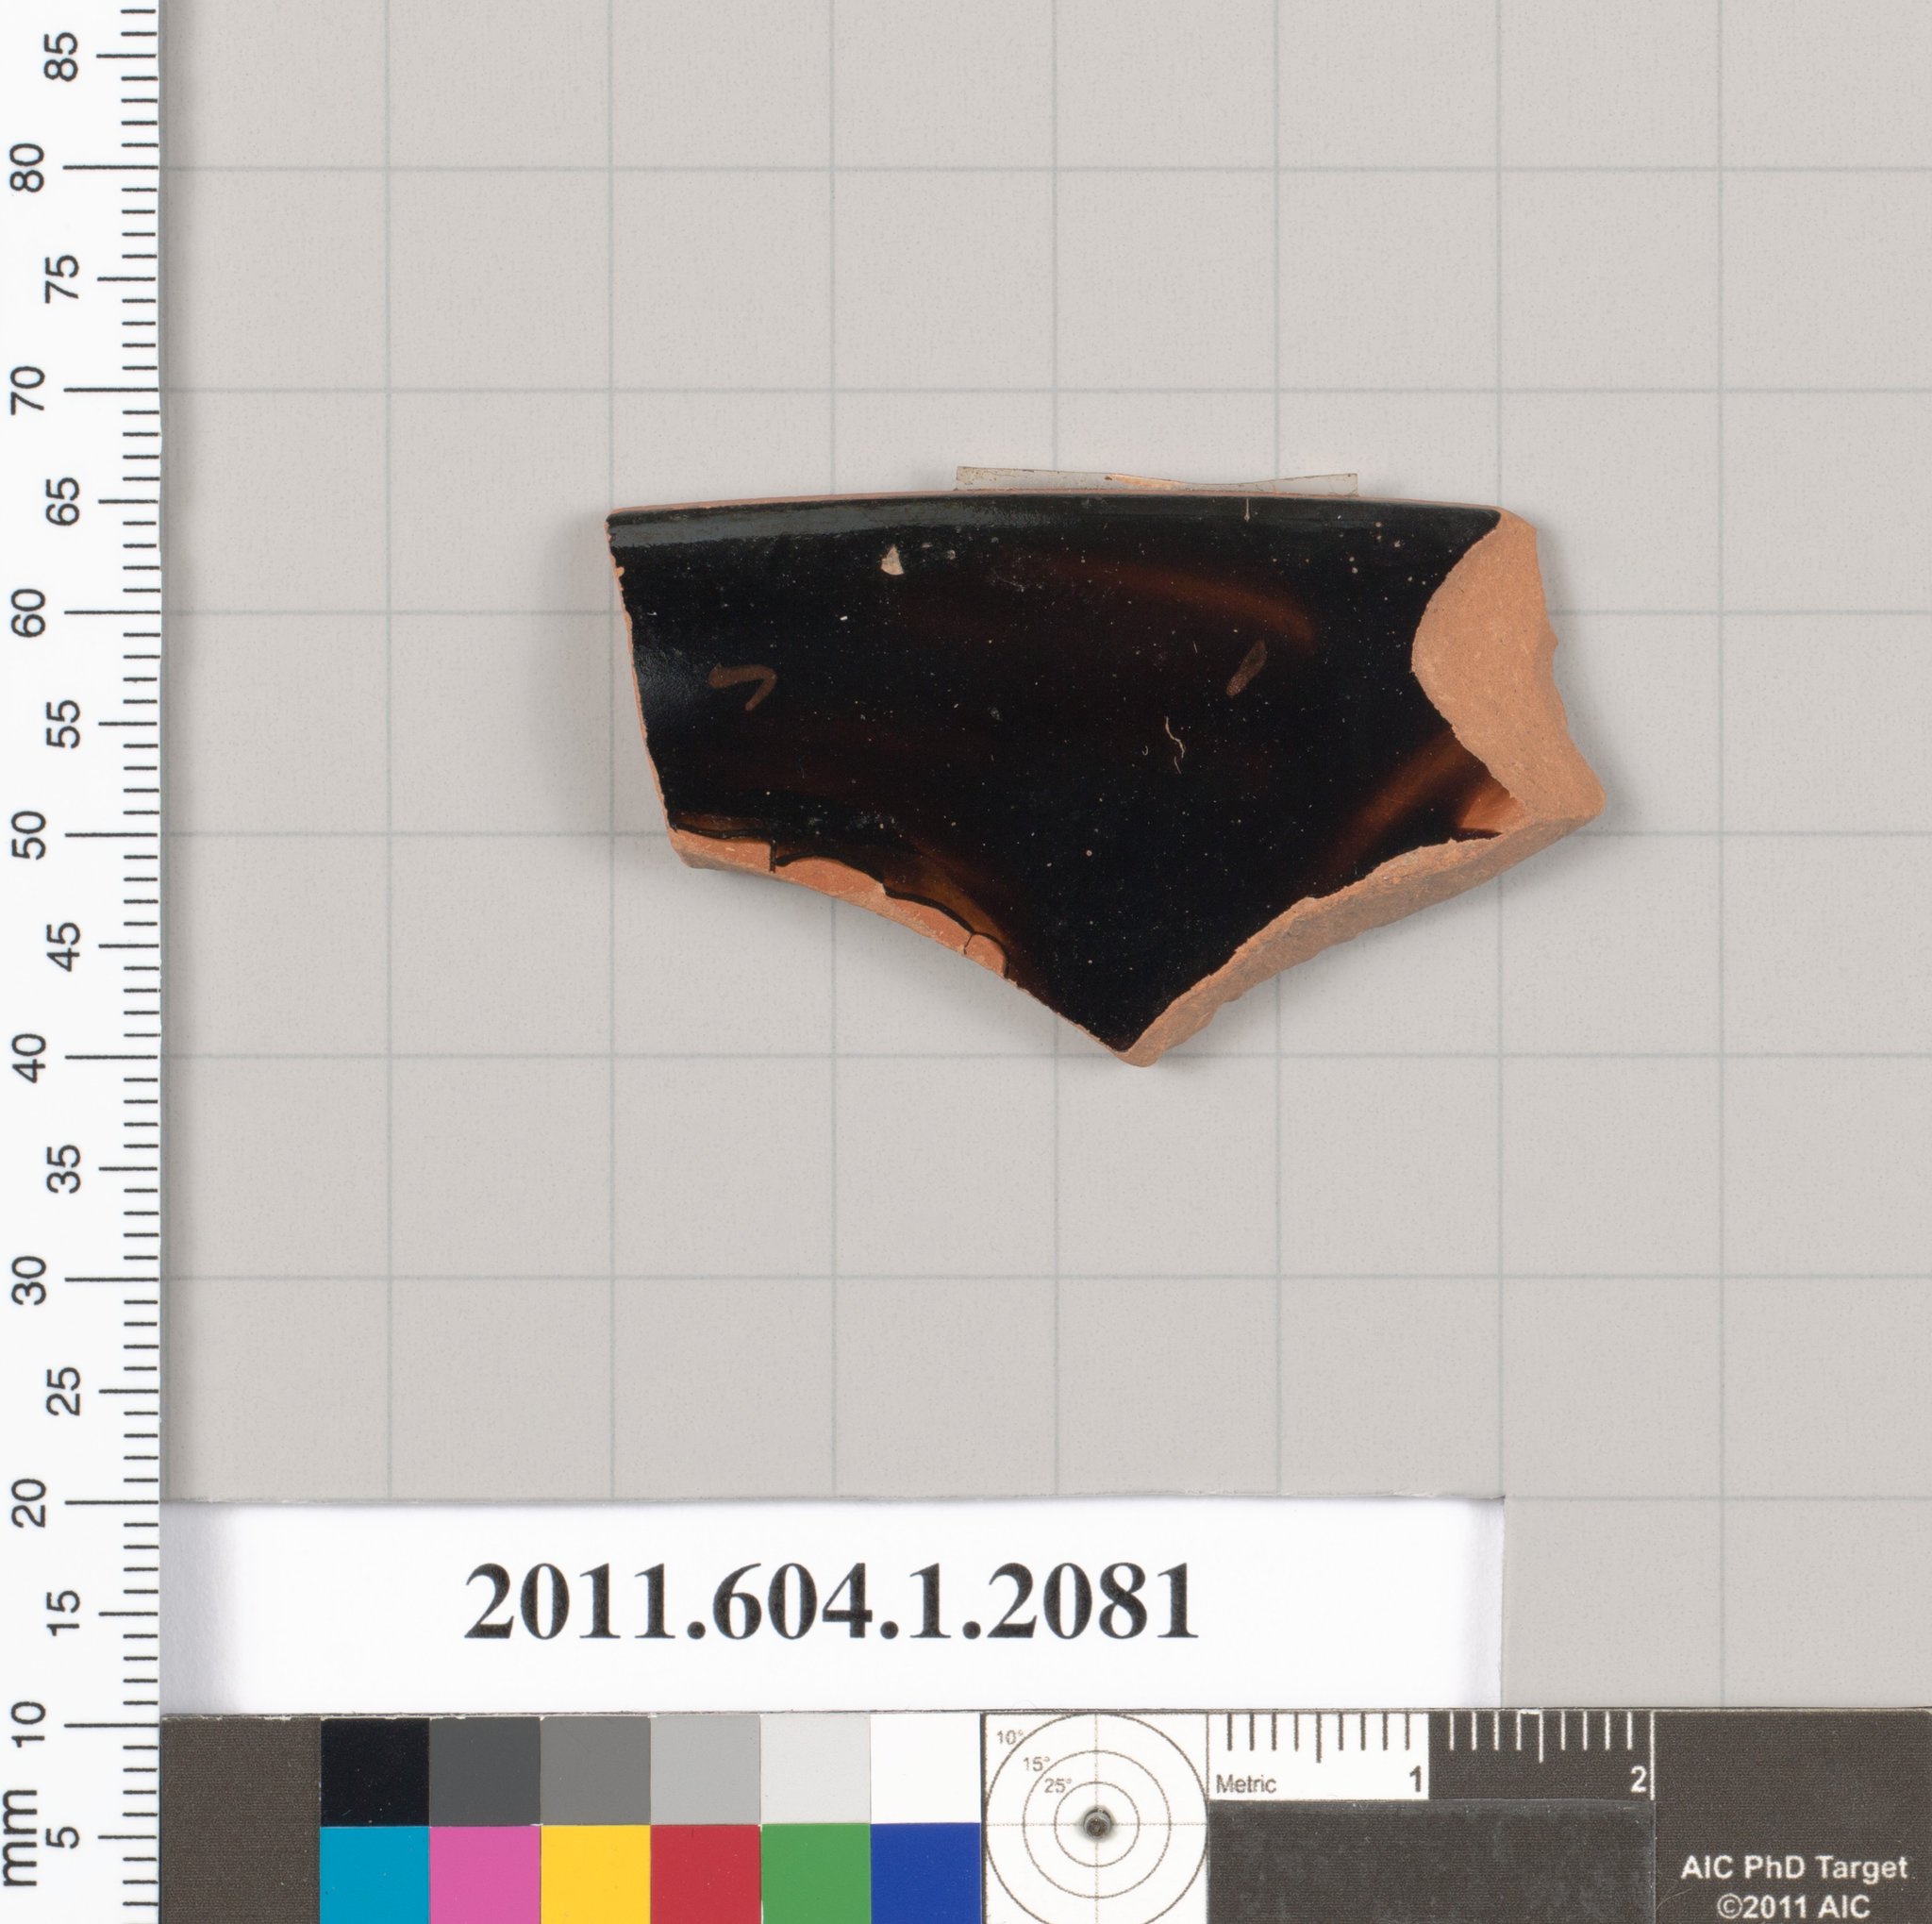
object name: kylix fragment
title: Terracotta rim fragment of a kylix (drinking cup)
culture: greek, attic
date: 500-401 BCE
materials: terracotta